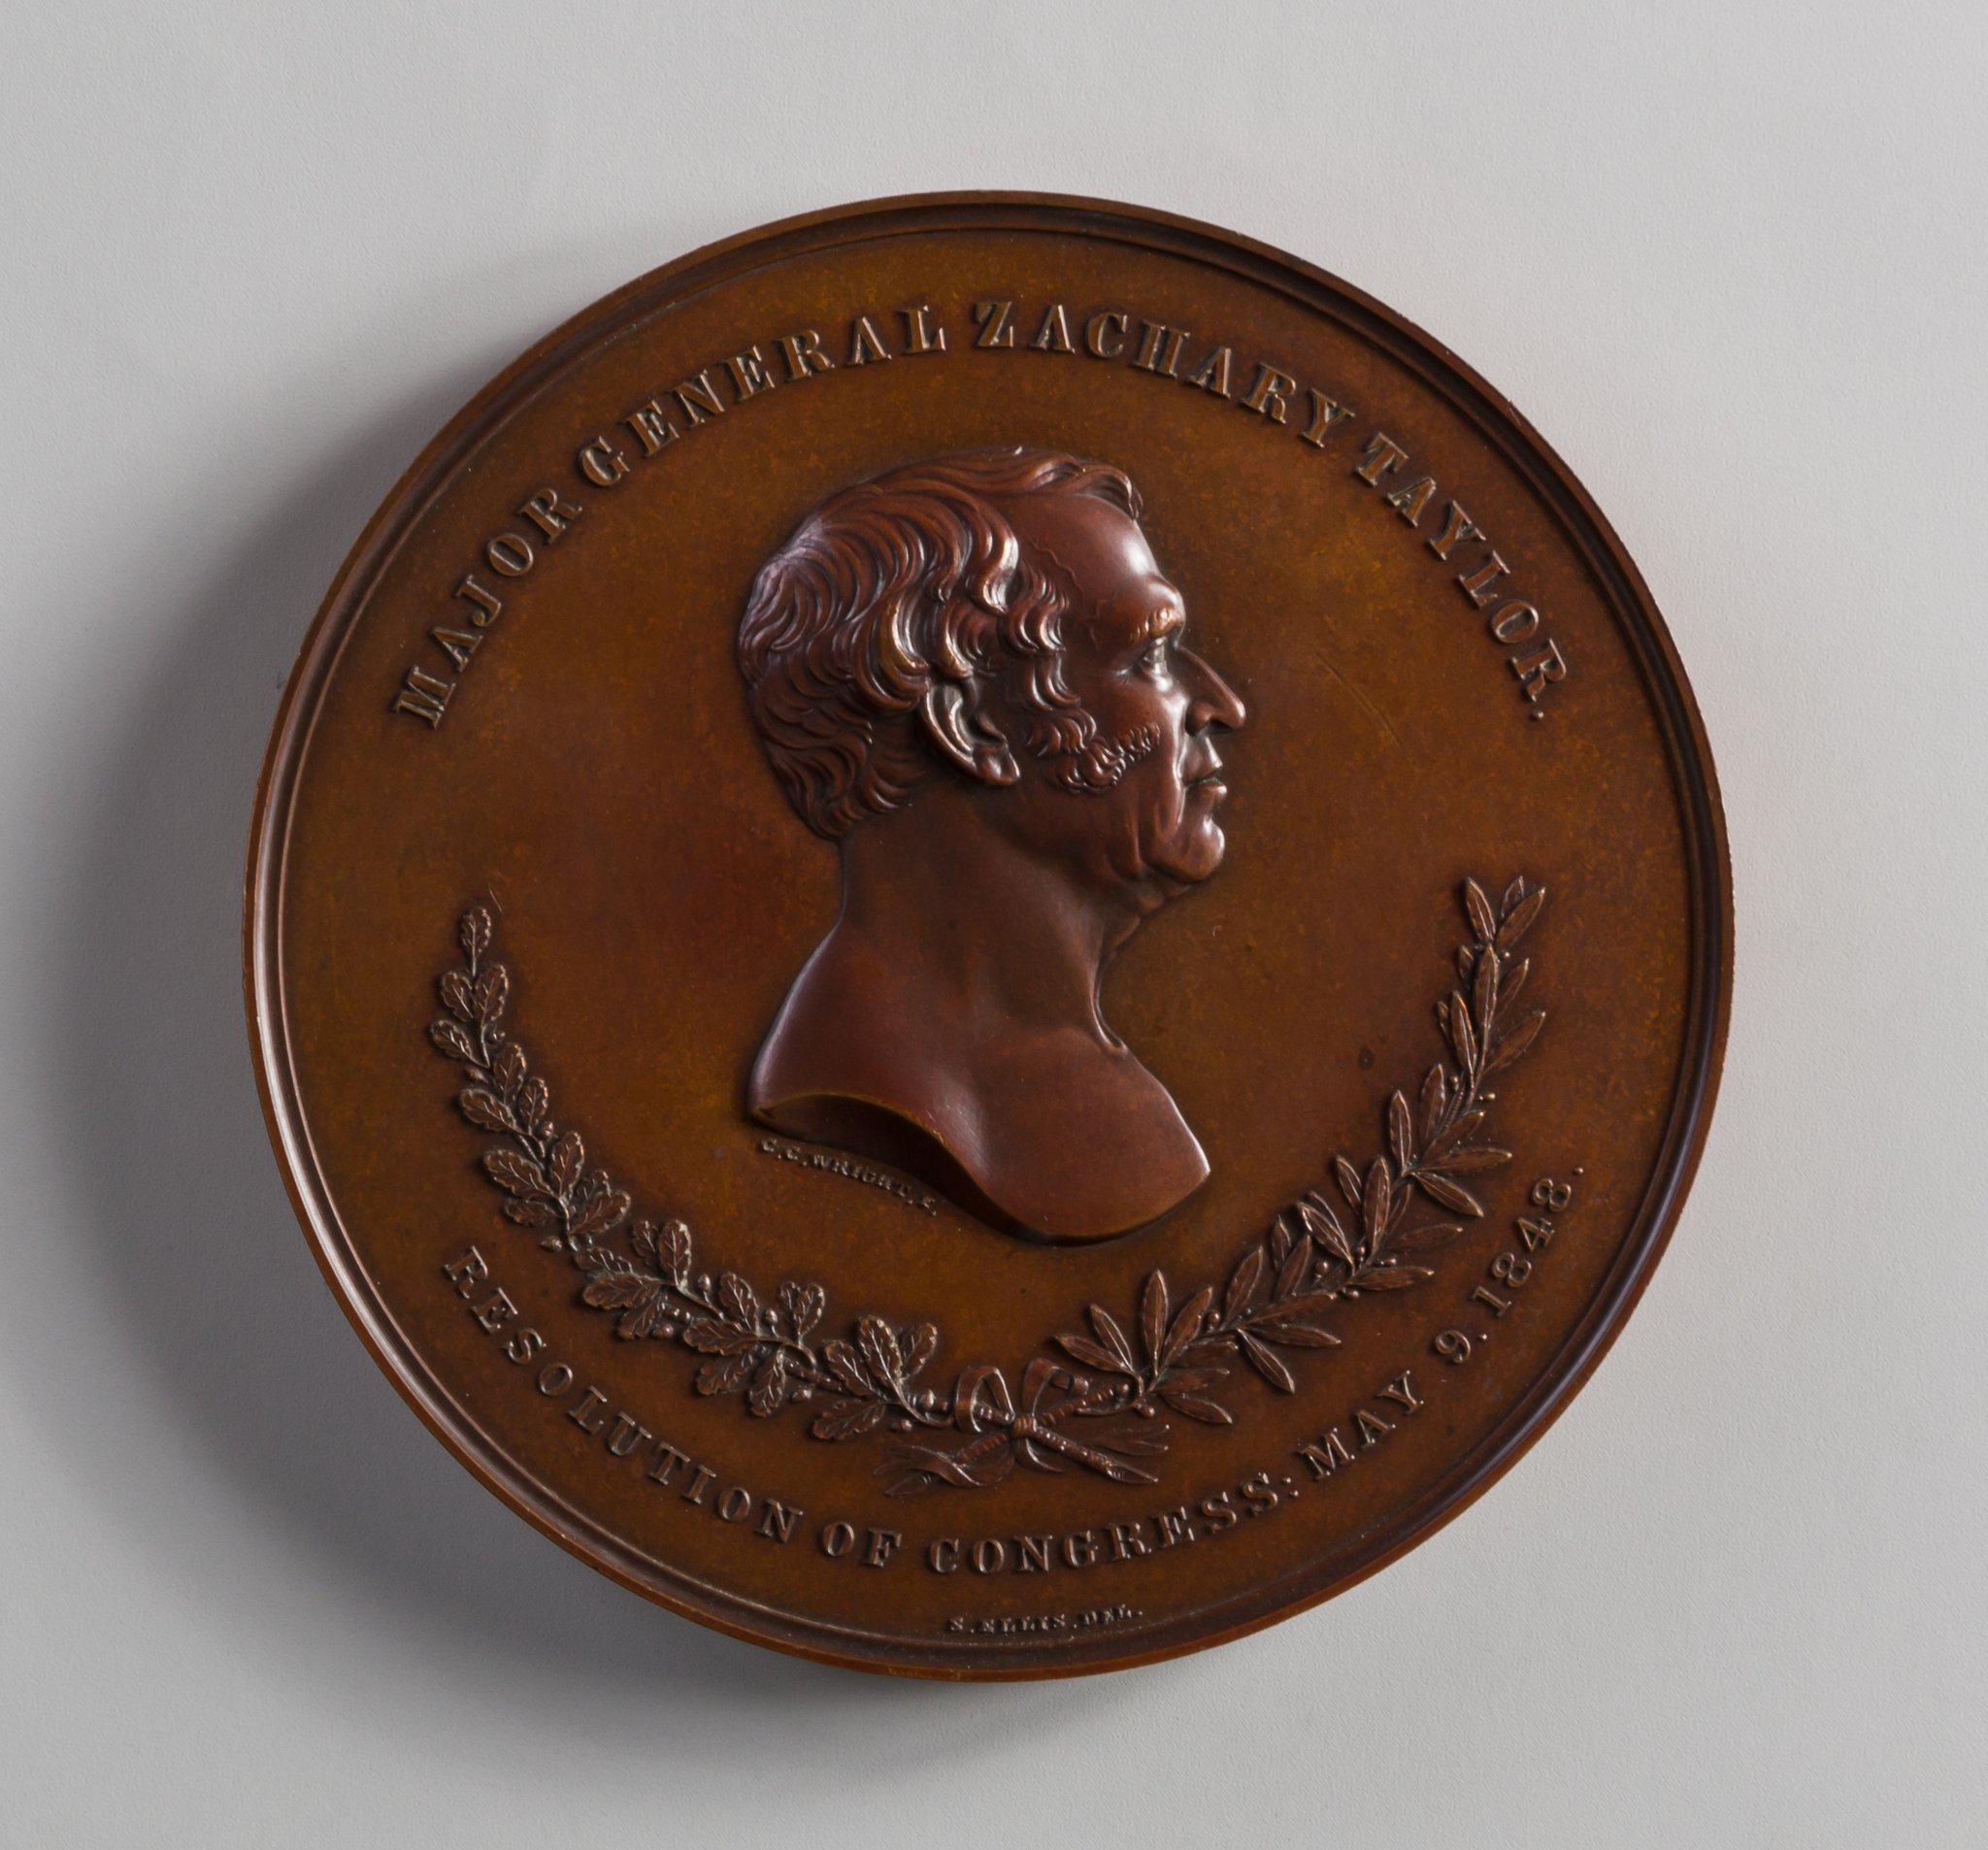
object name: medal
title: Medal of Major General Z. Taylor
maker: charles cushing wright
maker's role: maker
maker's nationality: american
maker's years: 1796-1854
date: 1848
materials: bronze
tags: men,profiles